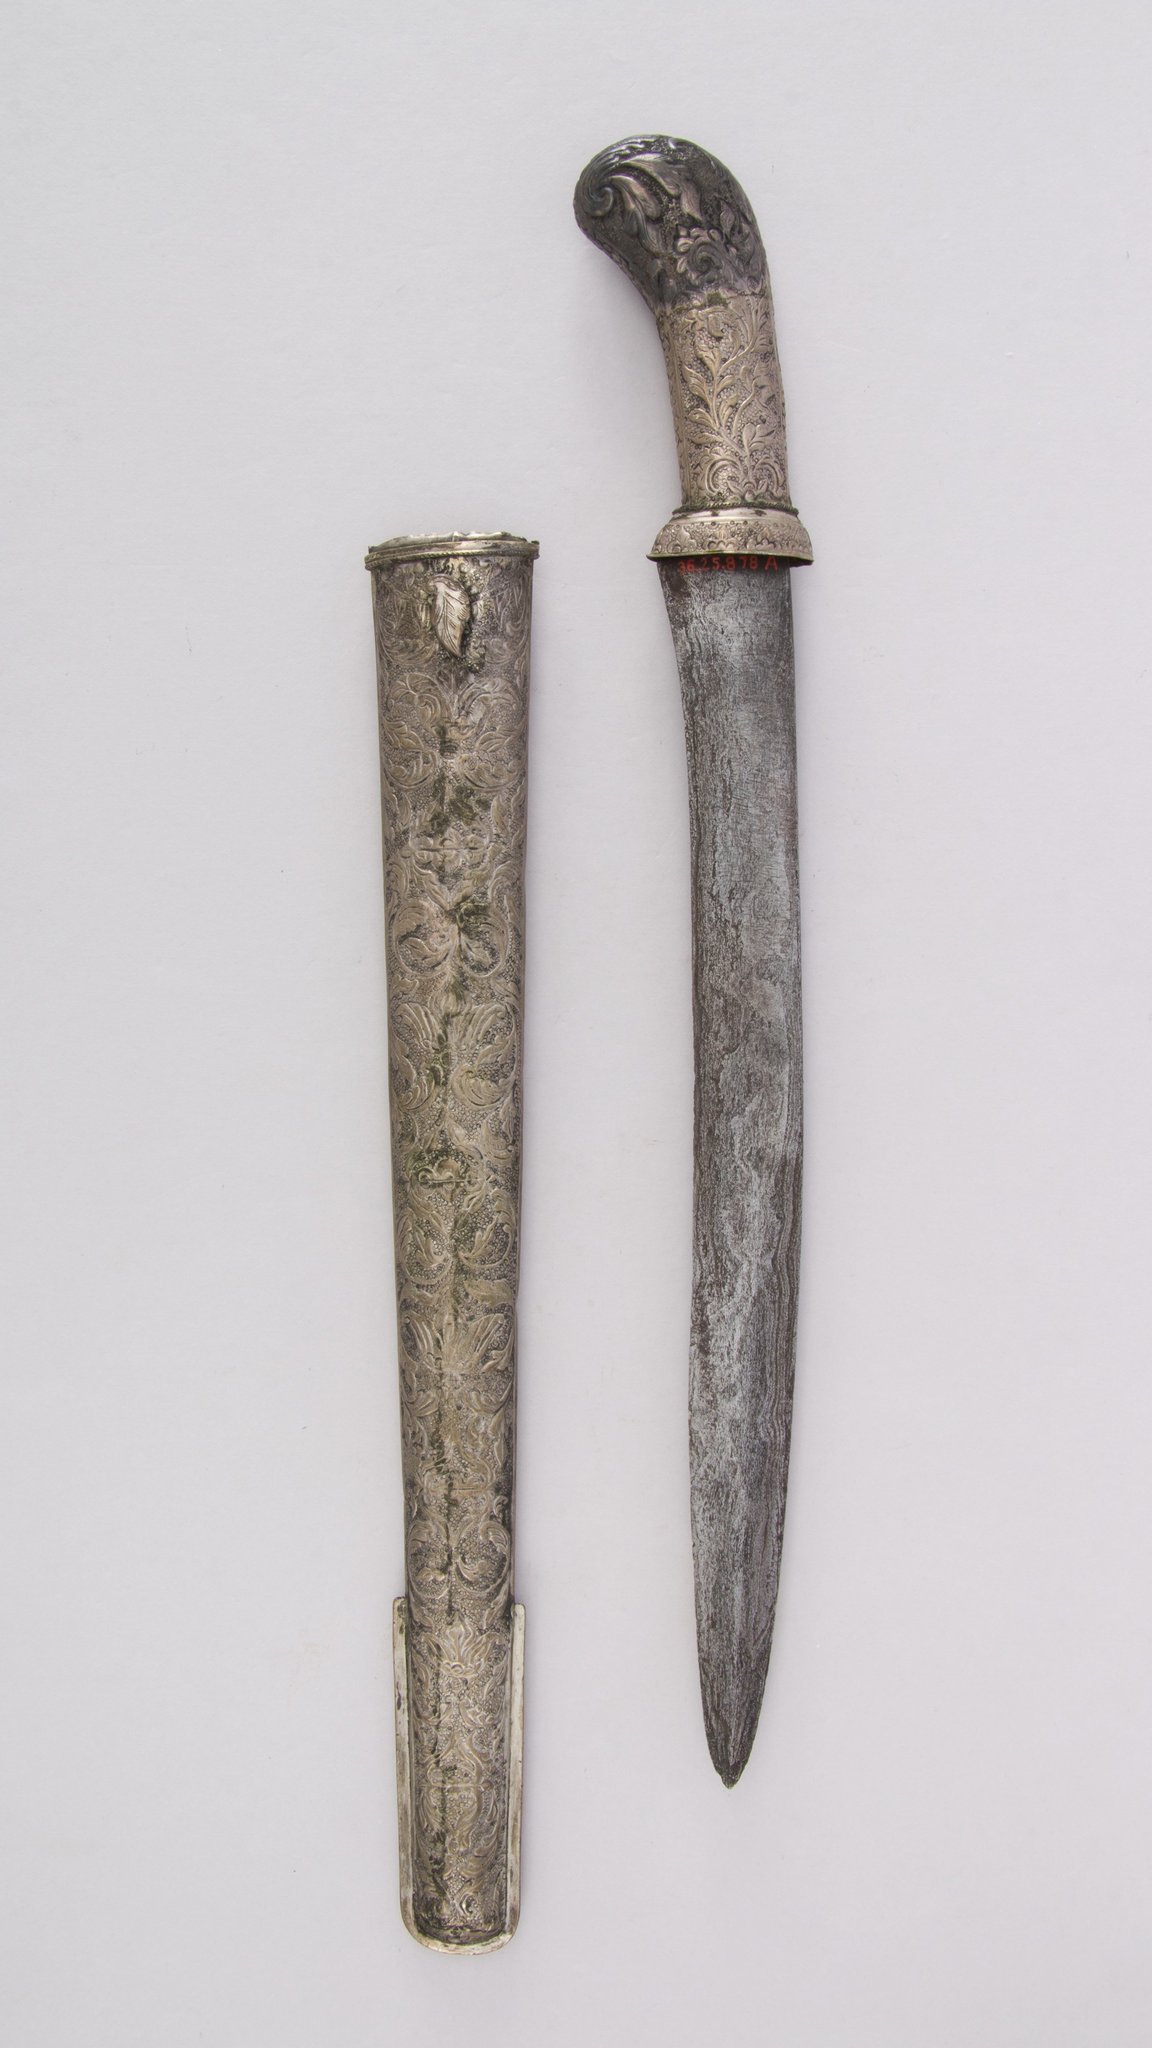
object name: knife with sheath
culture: javanese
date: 1501-1900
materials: iron, silver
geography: indonesia